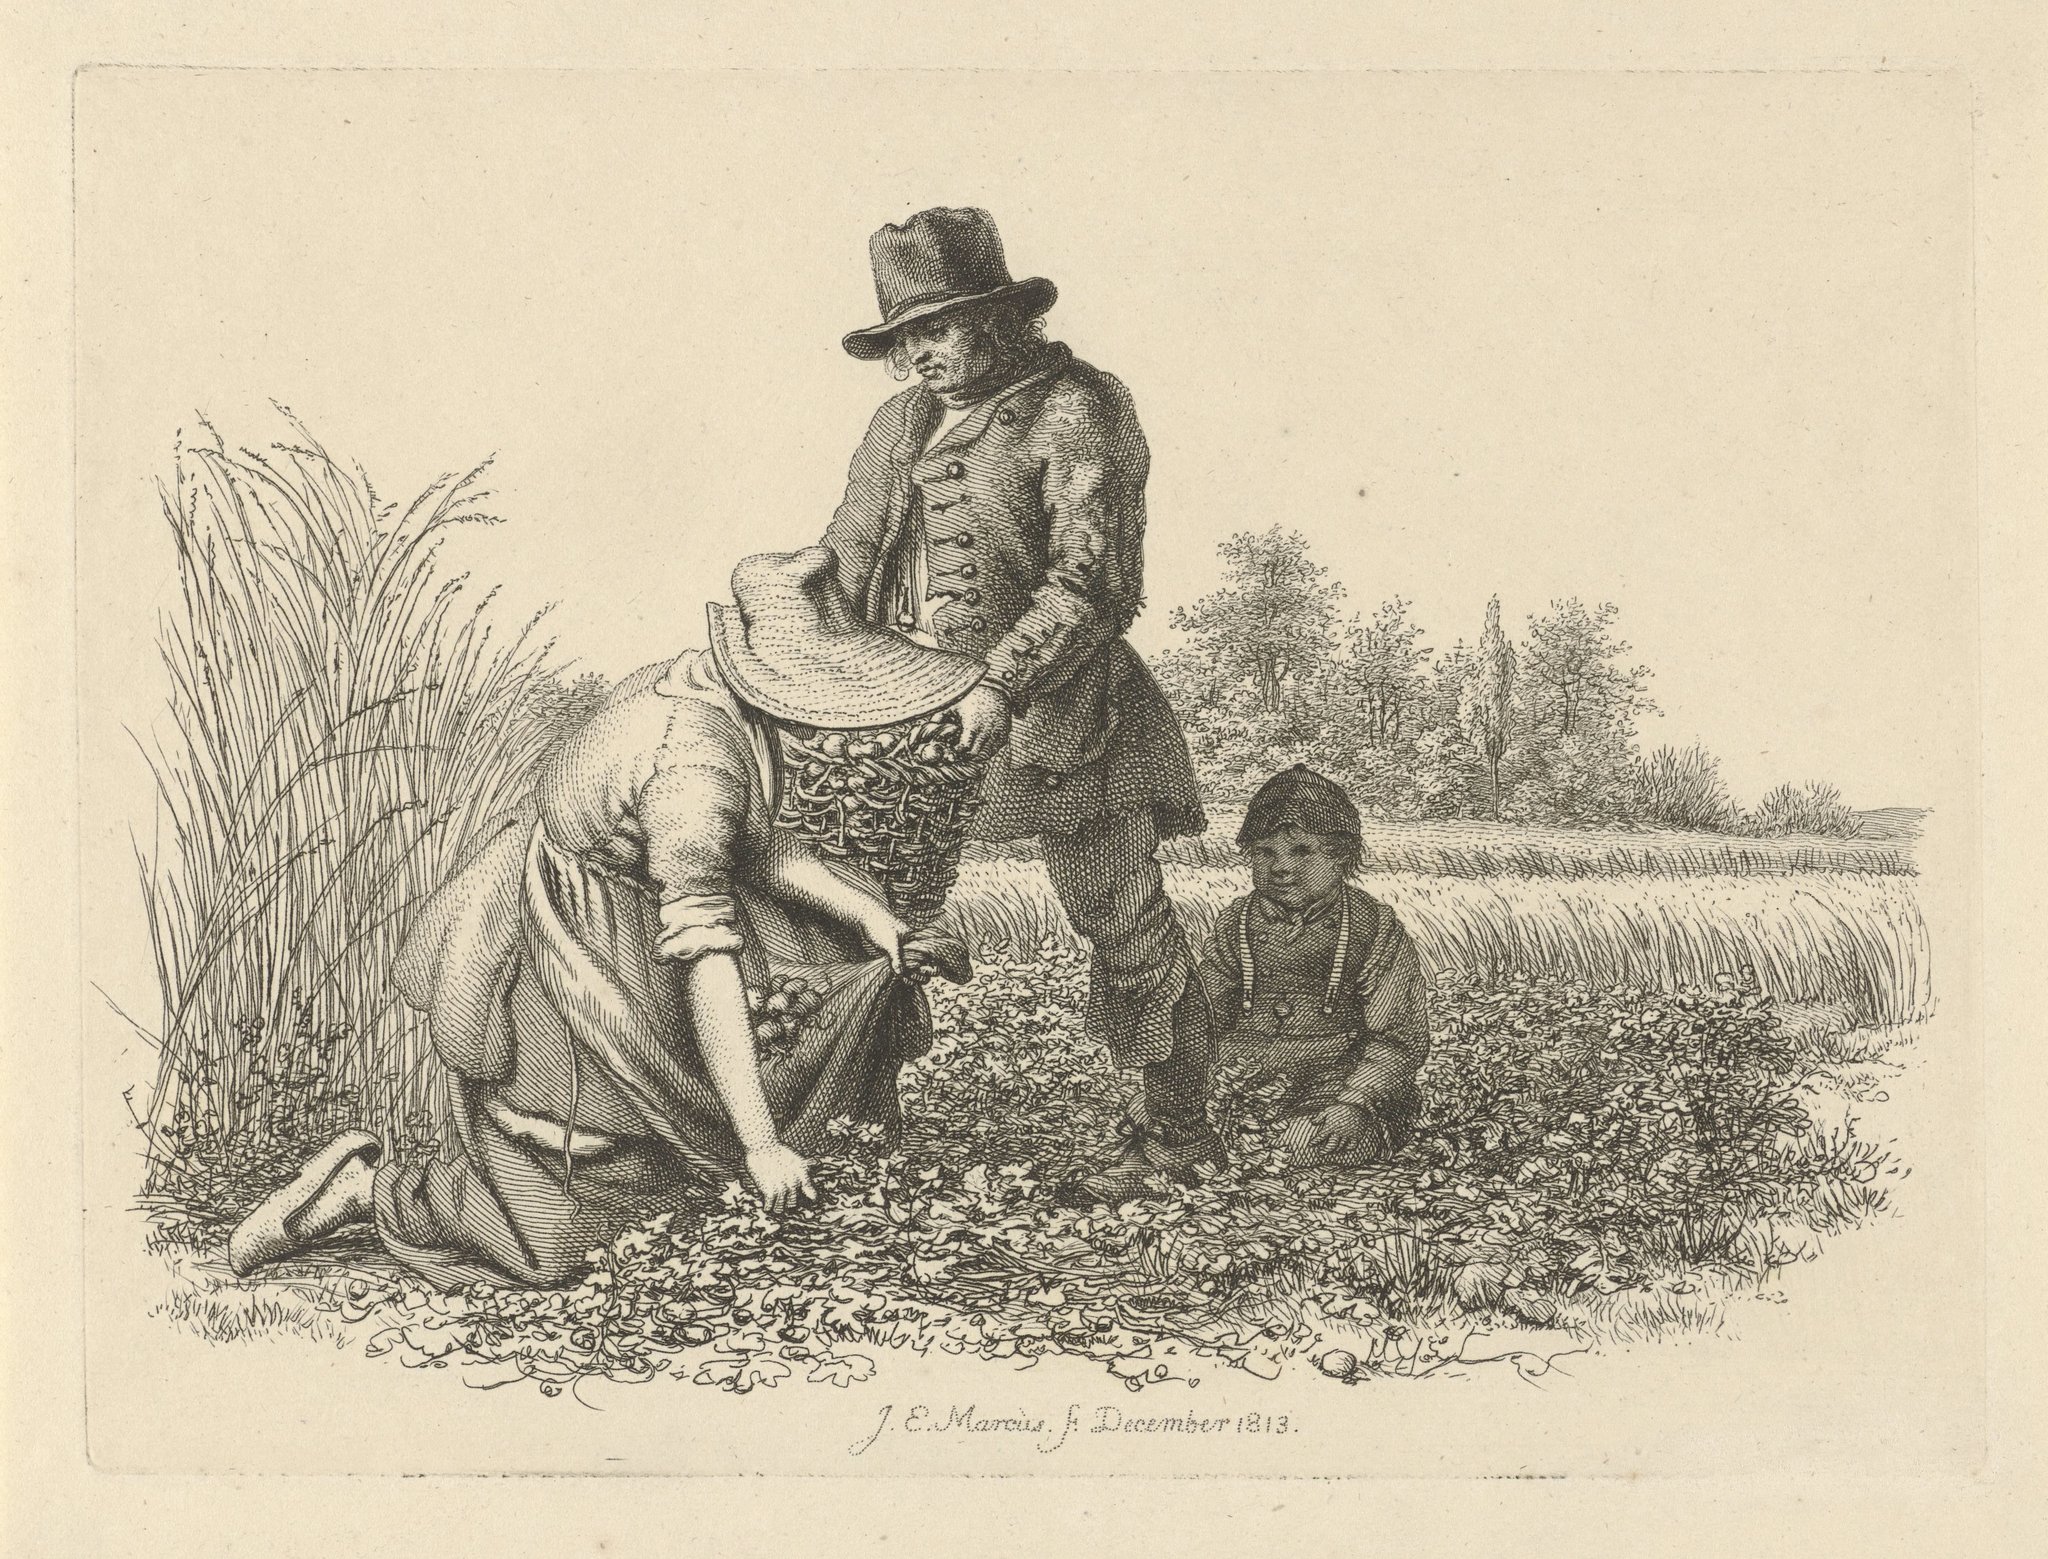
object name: print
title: Studie-prentwerk / Etudes gravées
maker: jacob ernst marcus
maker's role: draughtsman, print maker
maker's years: 1774-1826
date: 1812-1813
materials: paper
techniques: etching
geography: amsterdam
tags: harvest, kneeling figure - aa - female human figure (+ right side visible; right - (r. hand, r. foot, etc.)), toddler (male) (+ sitting on the ground), carrying something in basket, bag, rucksack, etc.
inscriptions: collector's mark: Lugt 2228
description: Serie voor het eerst uitgegeven door Jacob Ernst Marcus onder de titel Studiebeelden en Fragmenten. Amsterdam: ca.1816. Later heruitgegeven als: Studie-prentwerk/ Etudes gravées.